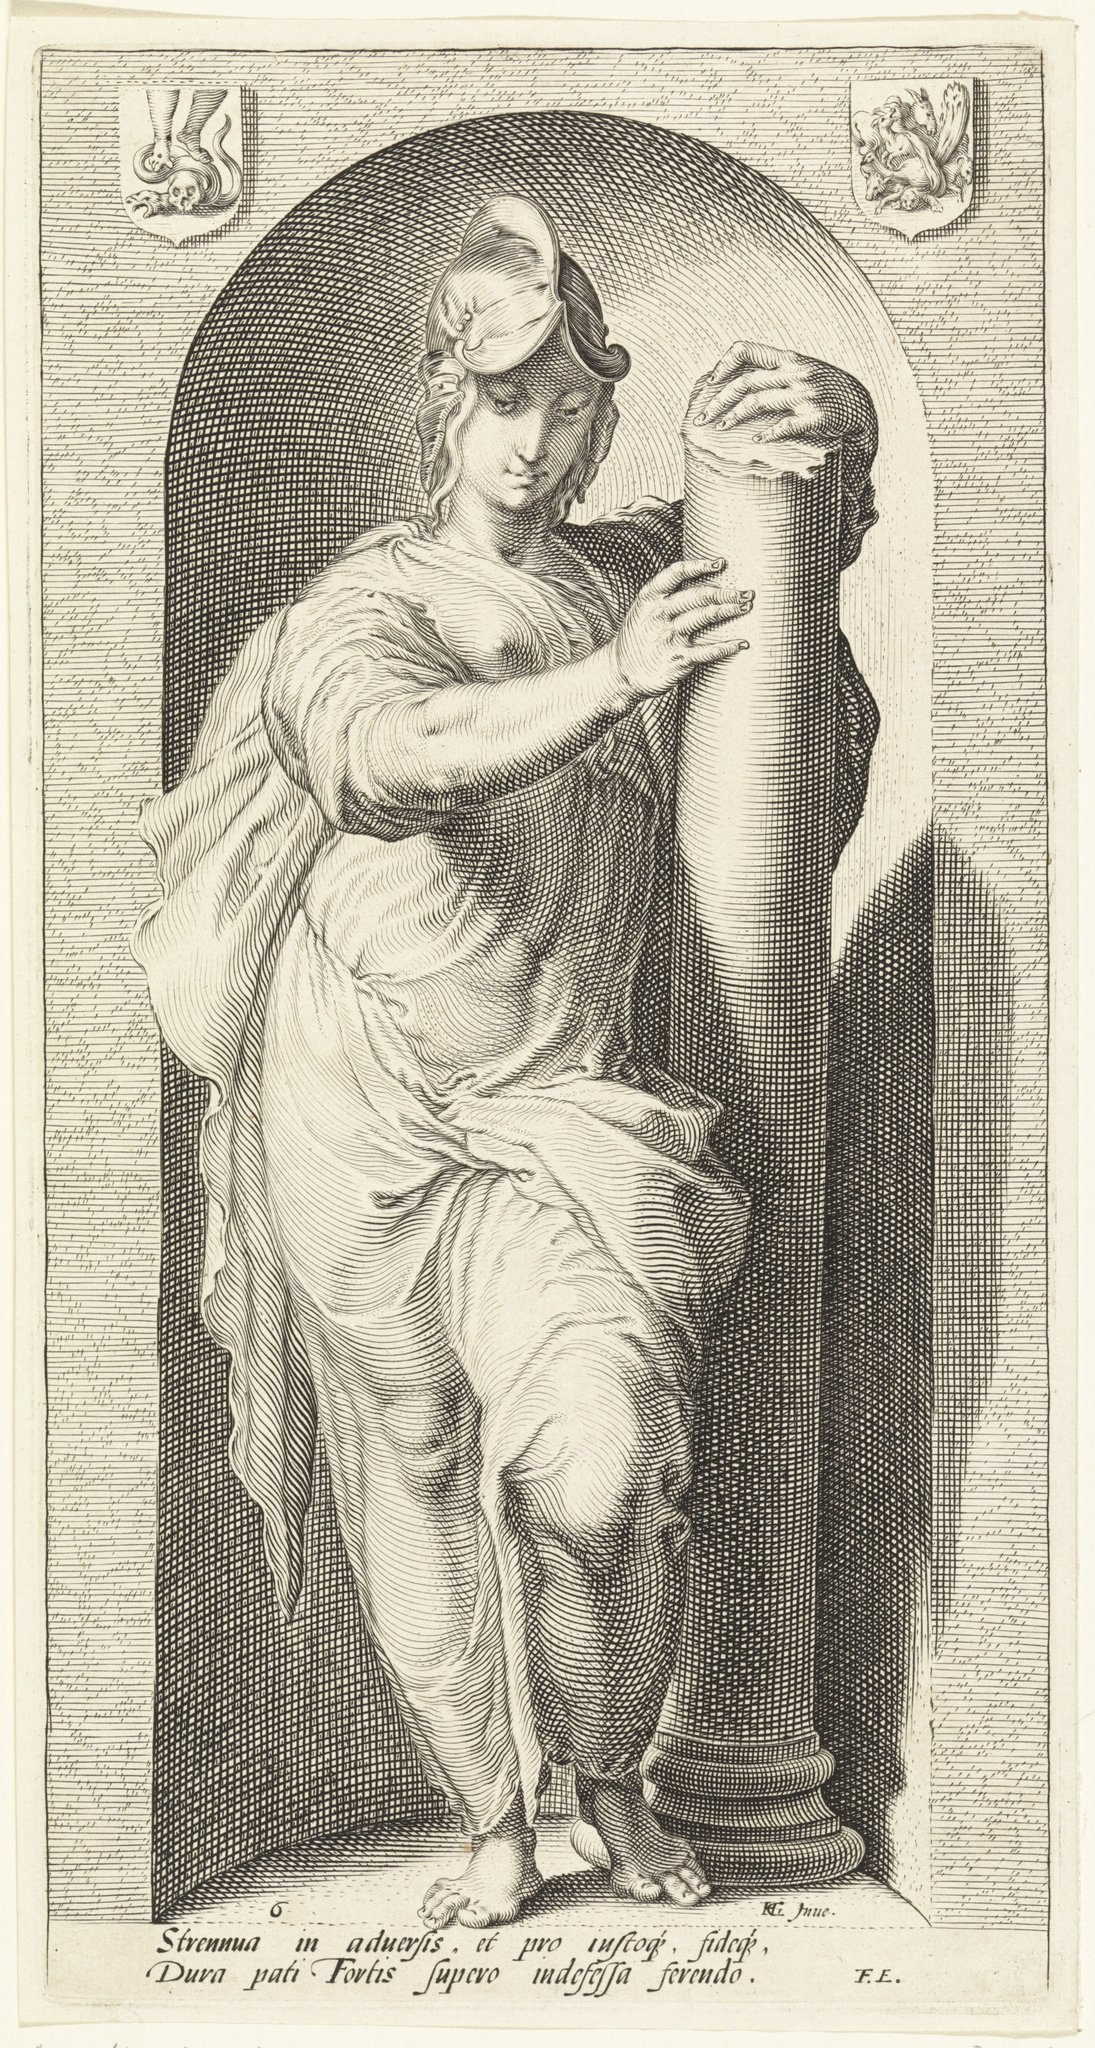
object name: print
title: Kracht (Fortitudo)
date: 1593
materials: paper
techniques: engraving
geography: northern netherlands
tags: fortitude, 'fortitudo' ~ one of the four cardinal virtues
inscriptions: collector's mark: Lugt 2228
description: Twee prenten uit deze serie zijn vervaardigd door J. Saenredam, de resterende vijf door J. Matham.